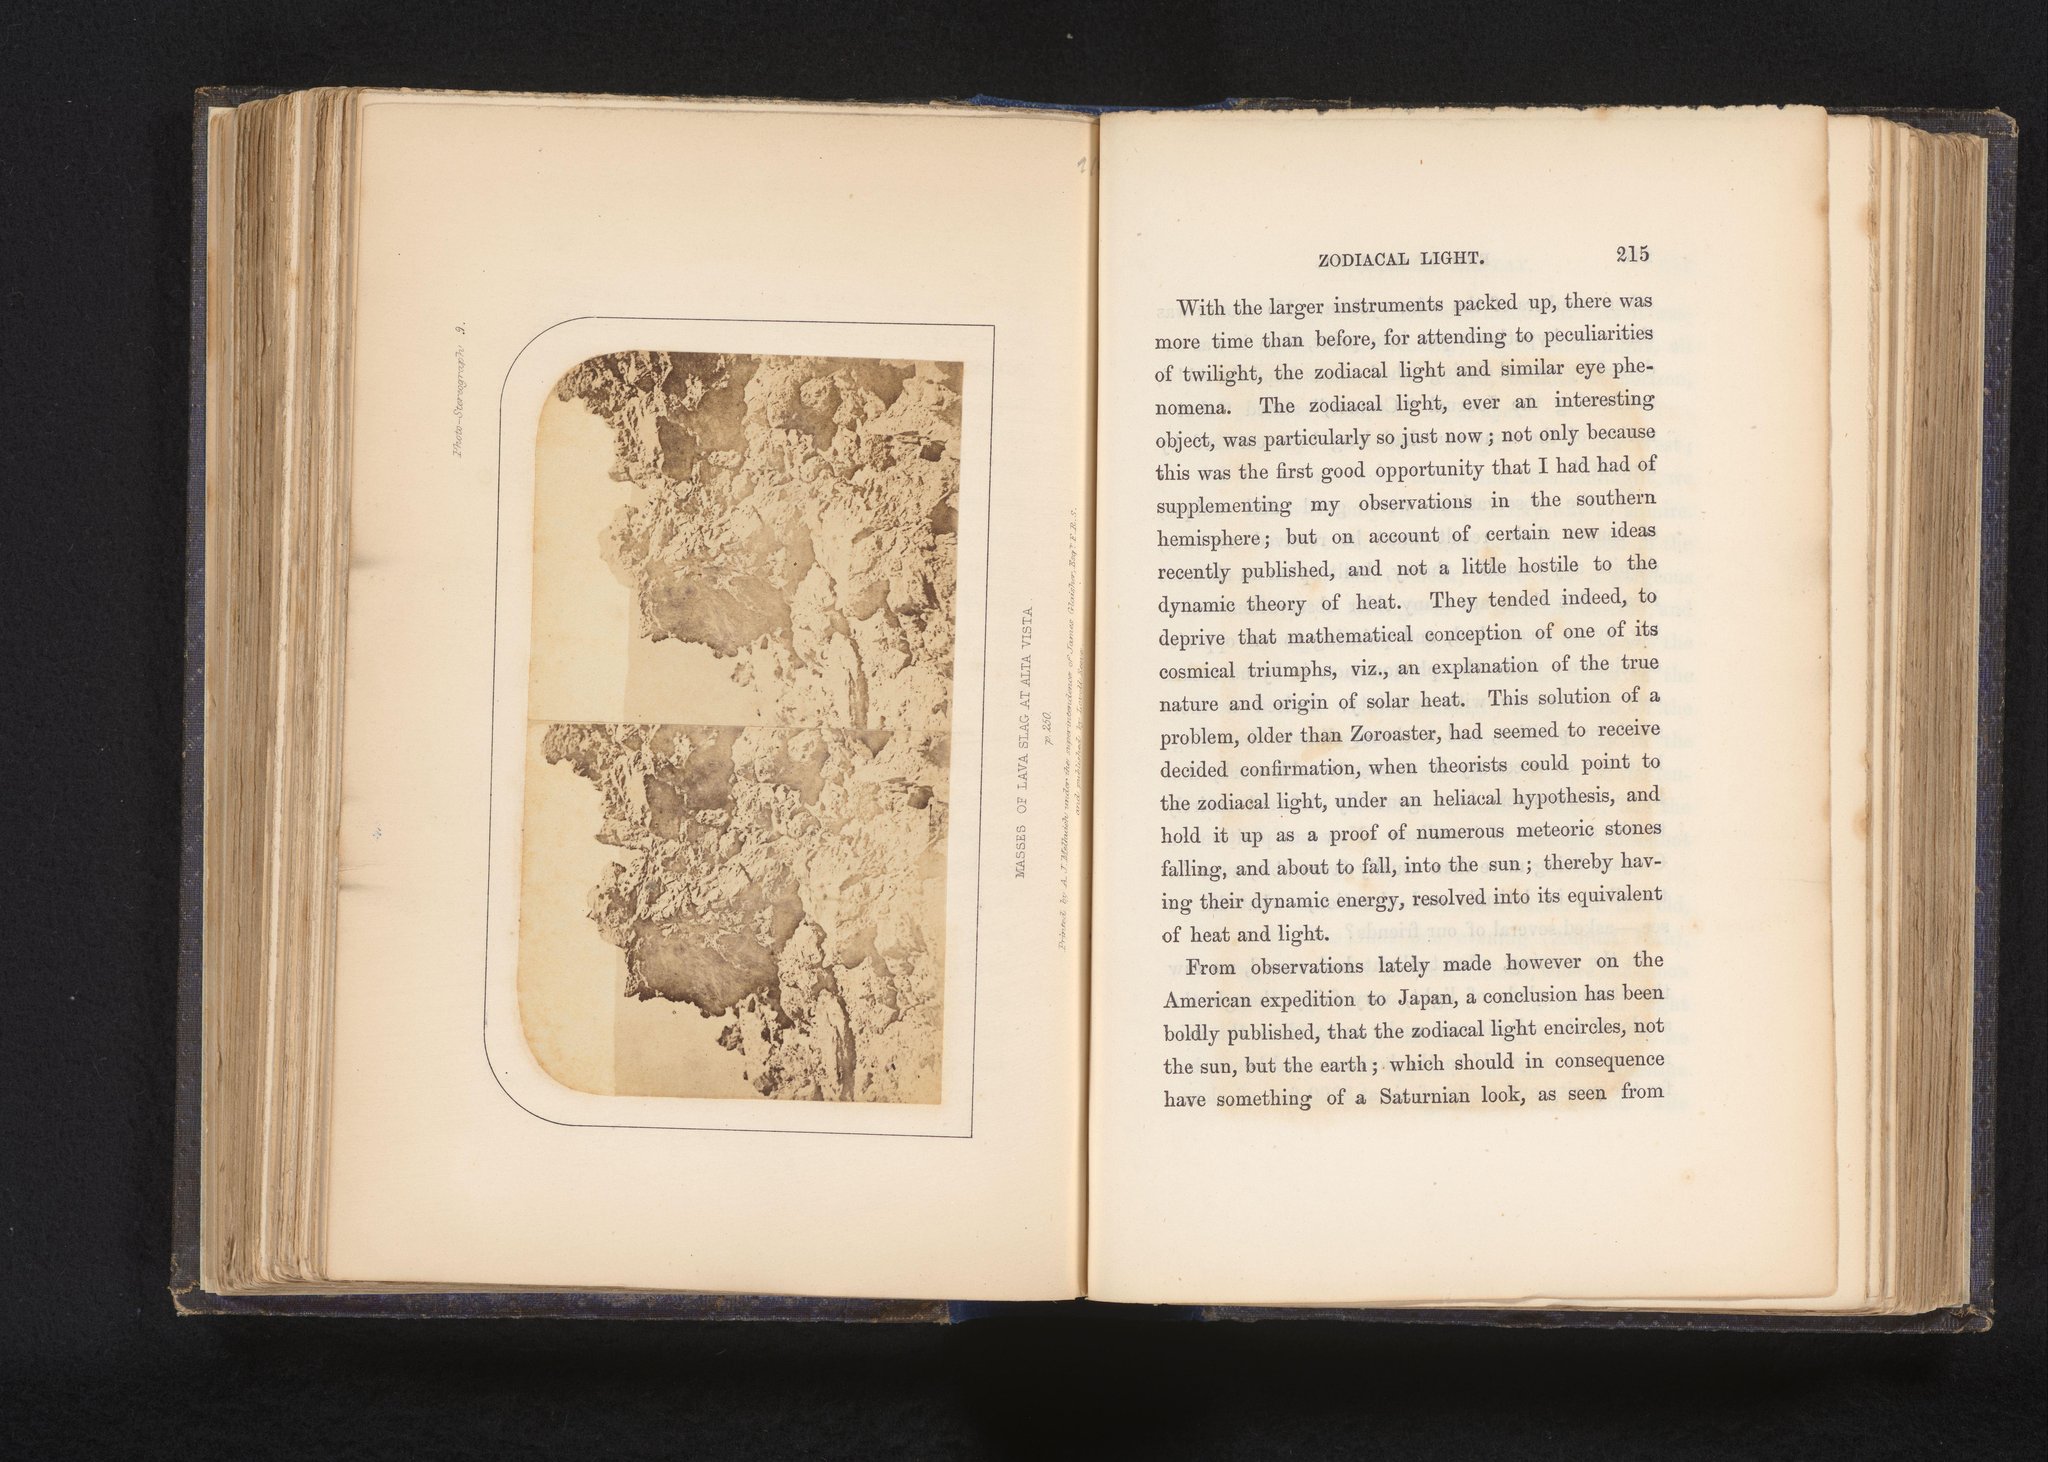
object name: page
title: Masses of lava slag at Alta Vista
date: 1856-1858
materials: paper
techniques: albumen print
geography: london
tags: cold lava, rock-formations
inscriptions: inscription: ‘Photo-Stereograph 9.’